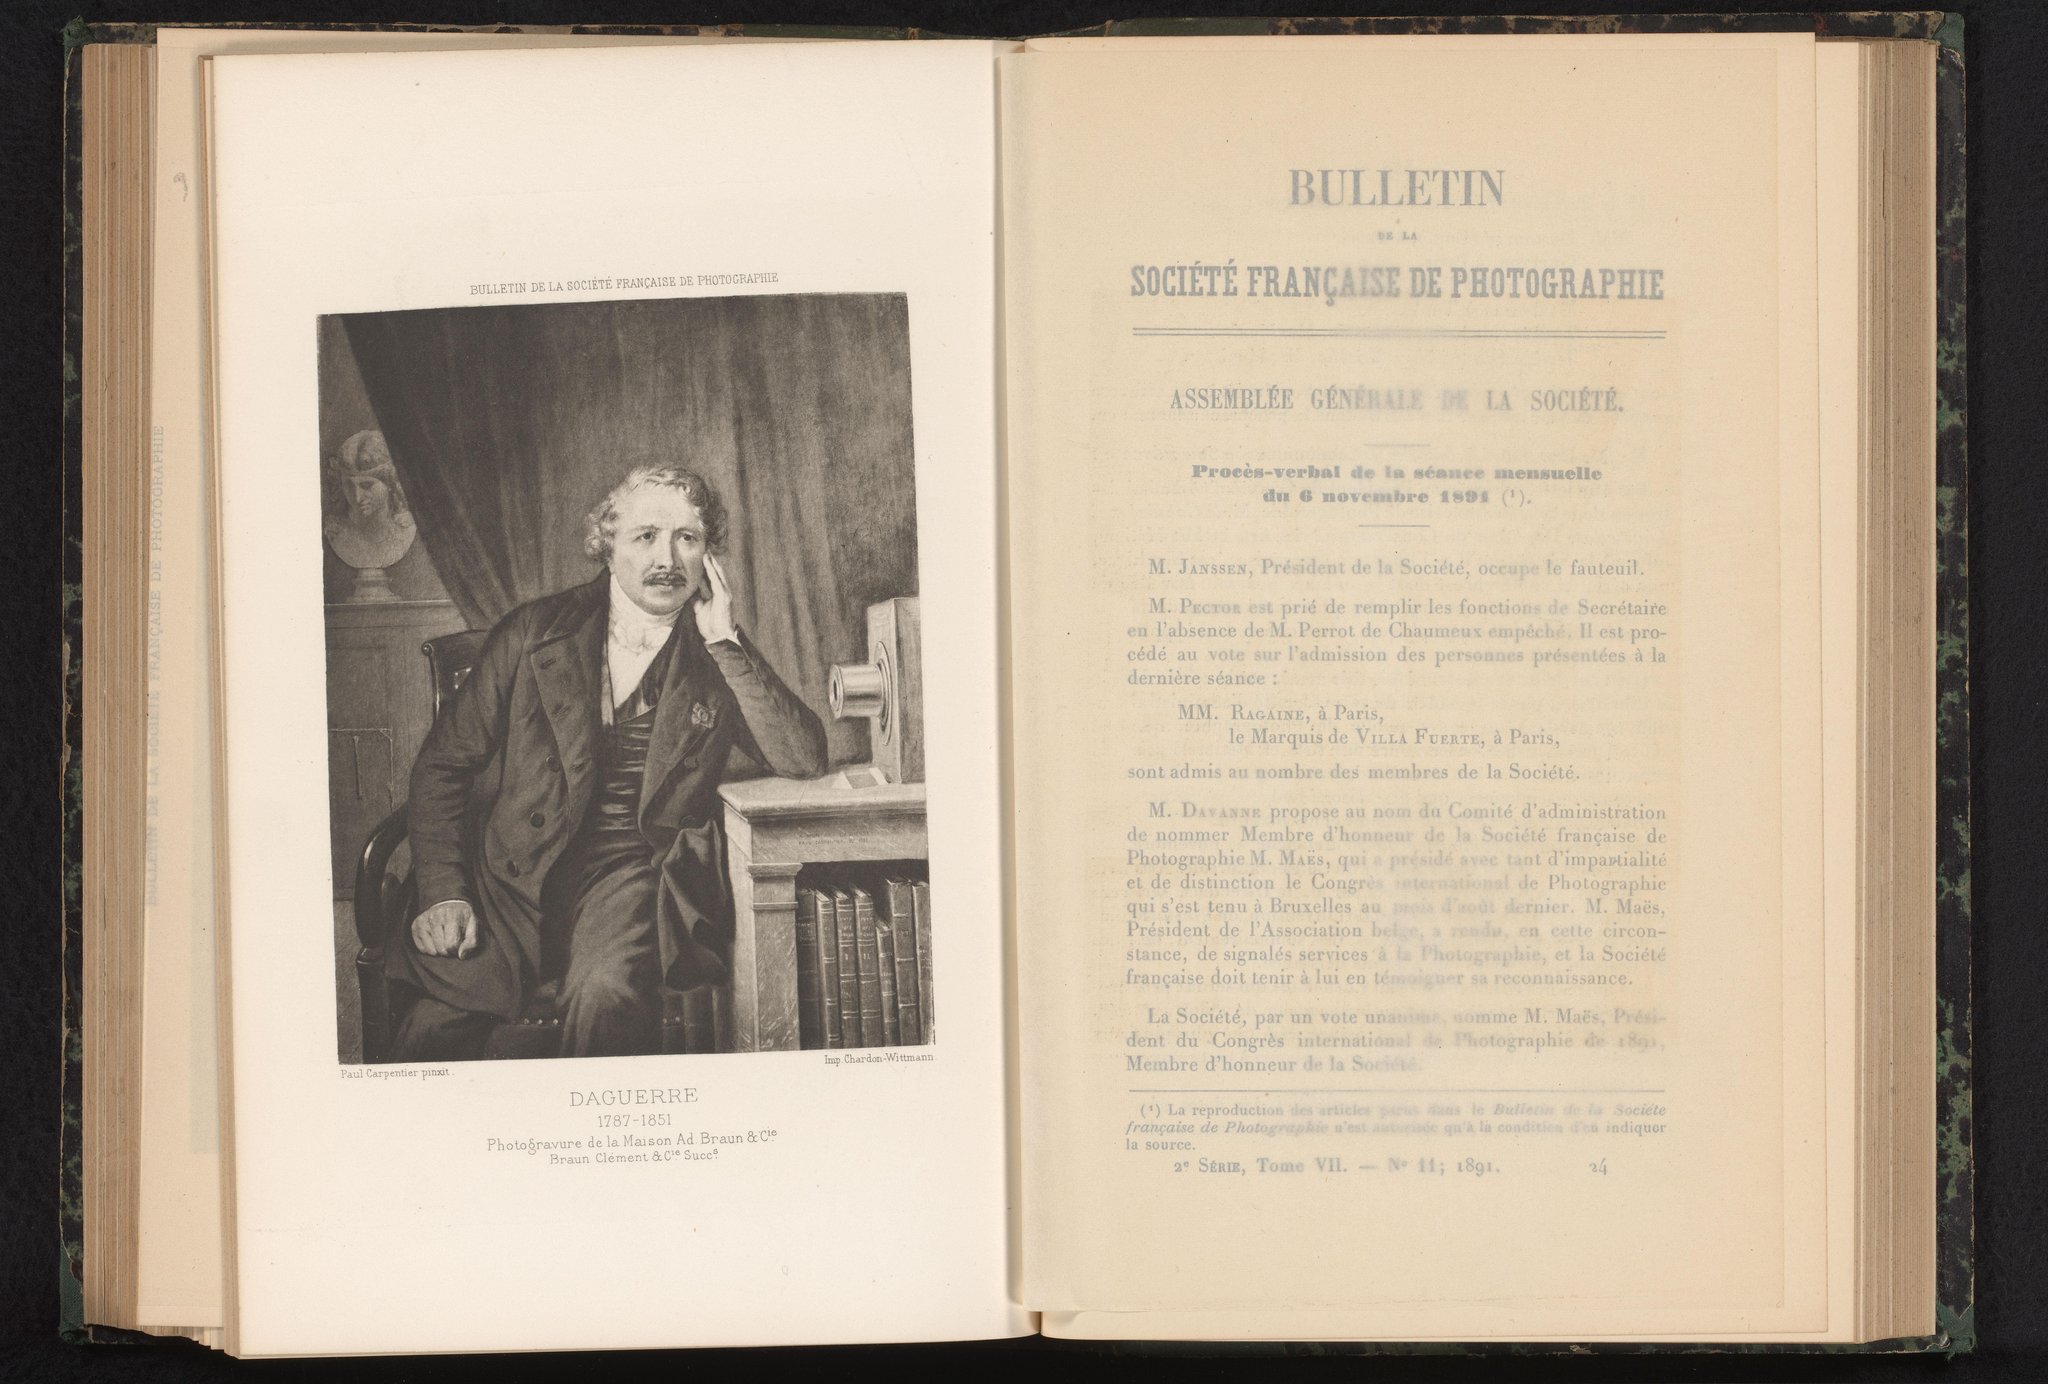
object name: reproduction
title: Reproductie van een geschilderd portret van Louis Jacques Mandé Daguerre door Paul Carpentier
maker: paul claude michel le carpentier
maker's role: painter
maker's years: 1787-1877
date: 1886-1891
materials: paper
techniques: photoaquatint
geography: paris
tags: louis jacques mandé daguerre, camera ~ photography, historical persons, portrait, self-portrait of photographer